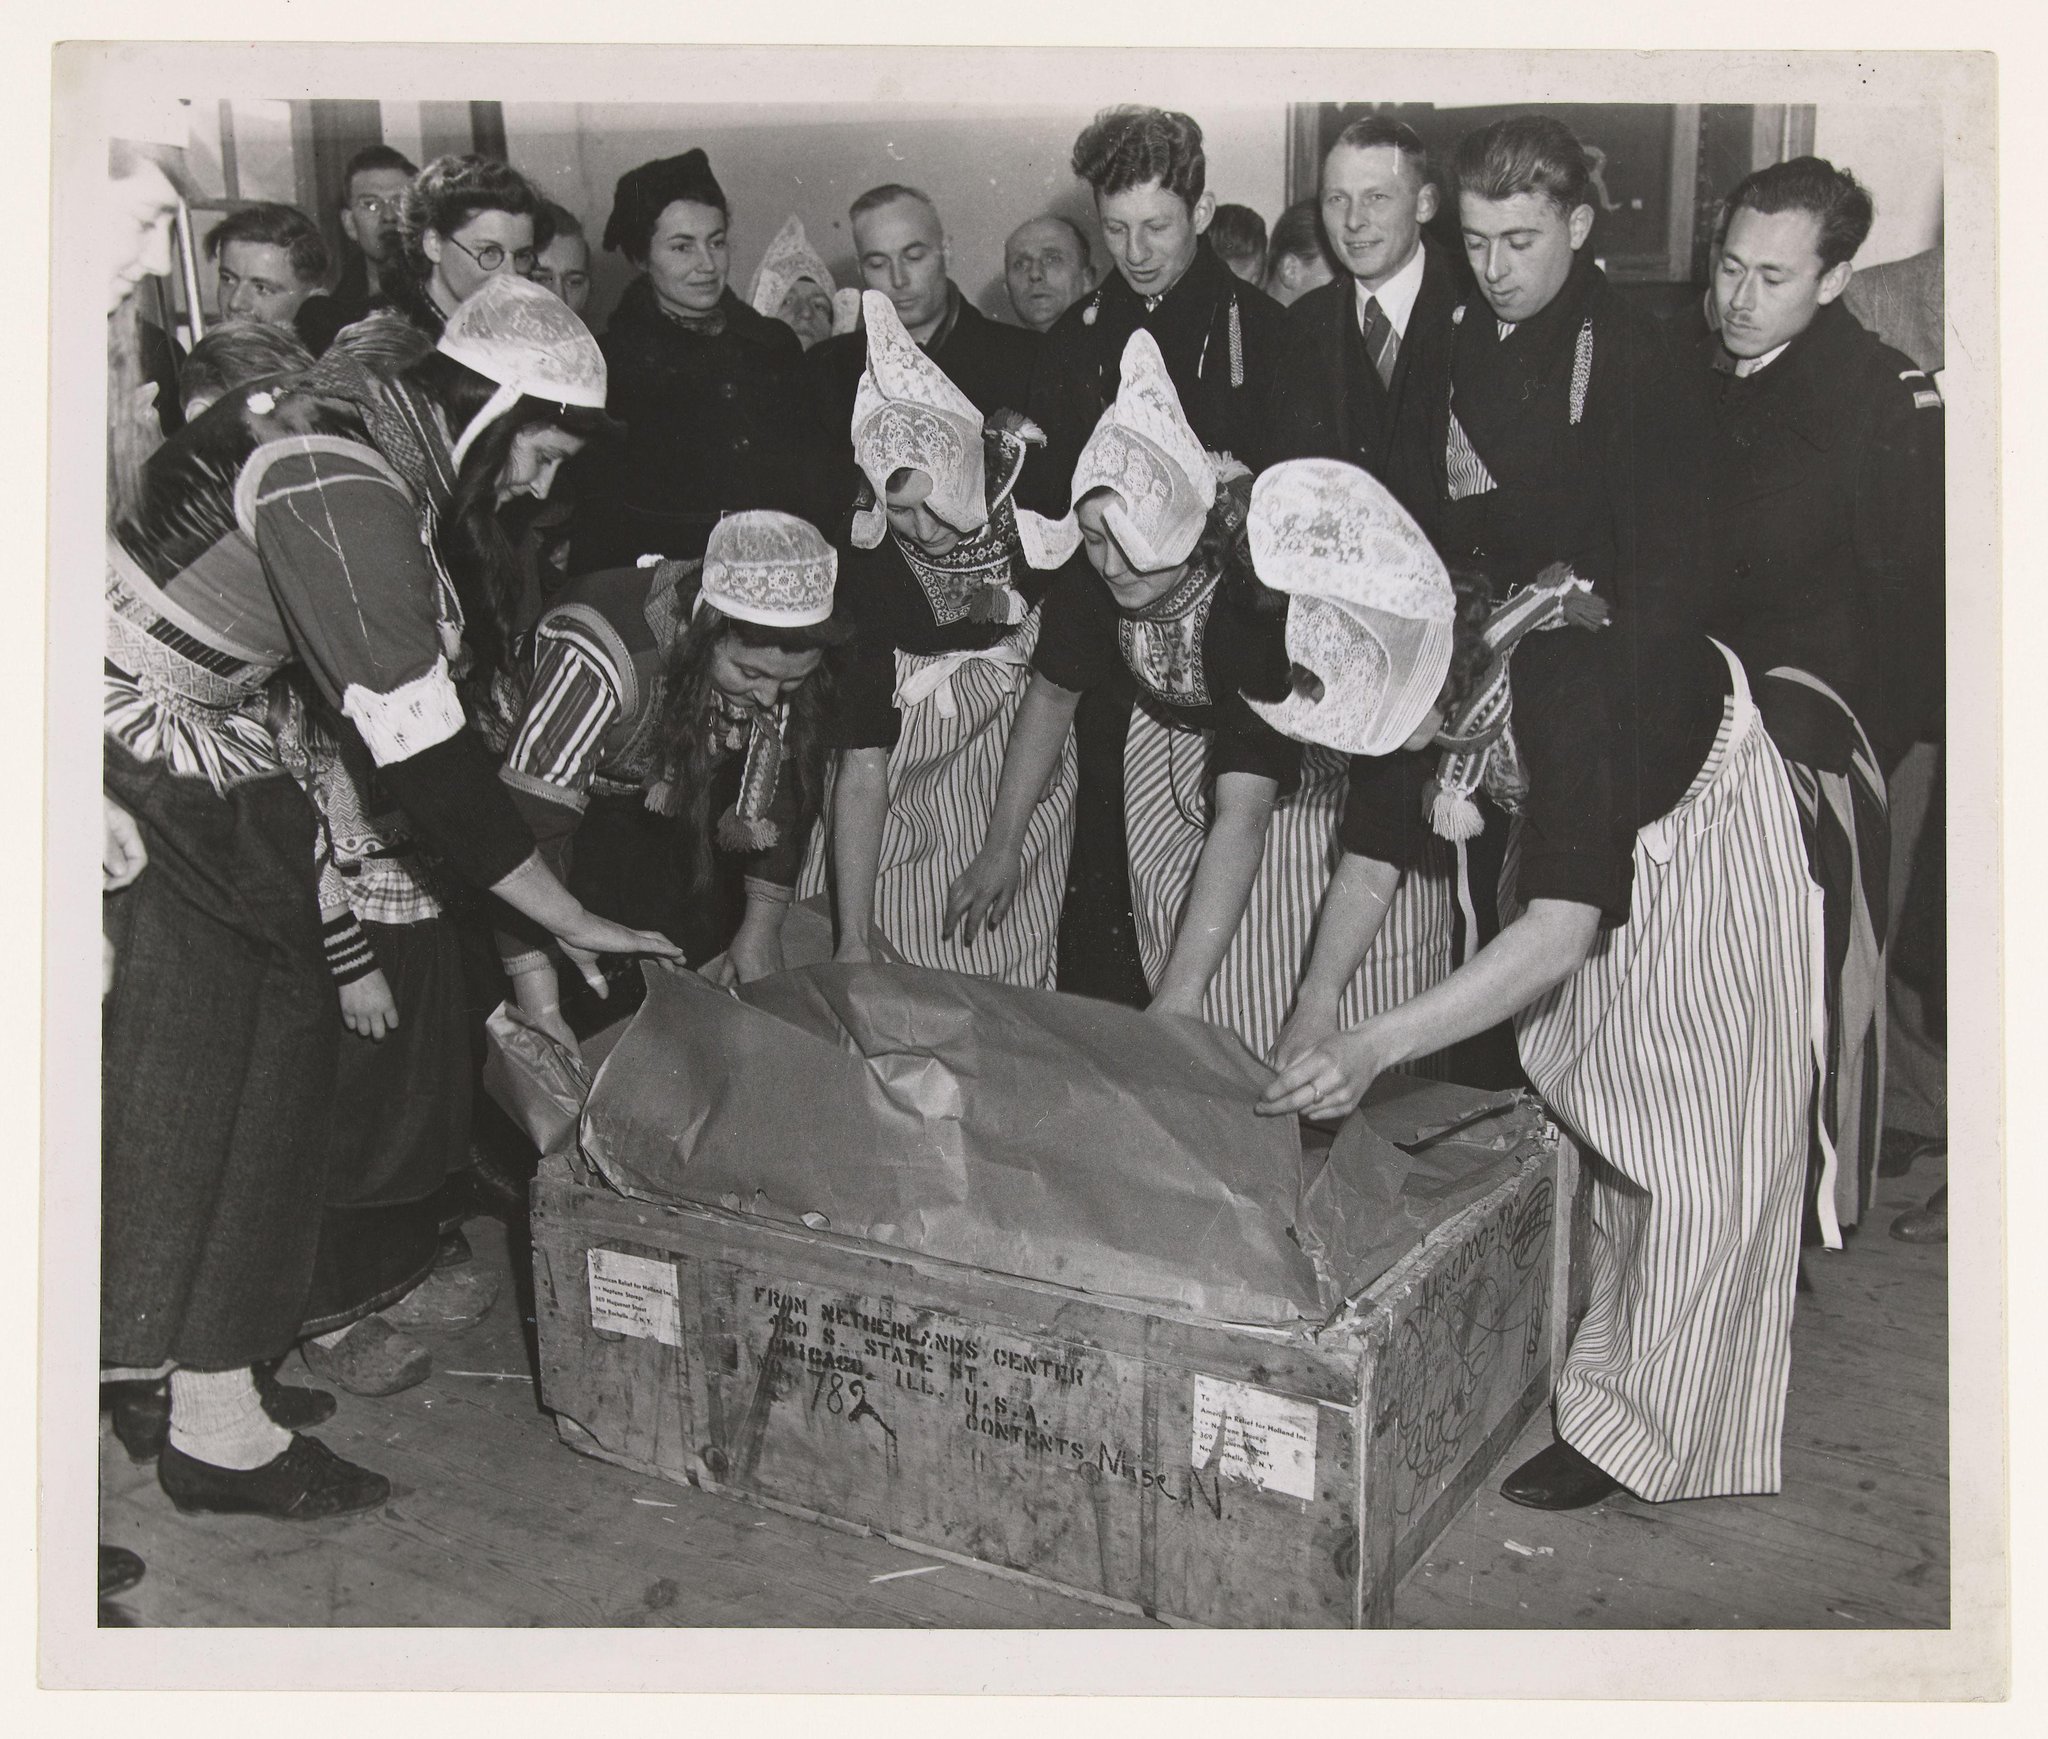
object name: documentary photograph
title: 1000e H.A.R.K. kist voor Volendam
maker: koos raucamp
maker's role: fotograaf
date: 1912-1945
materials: photographic support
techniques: photography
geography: volendam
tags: ons vrije nederland, volendam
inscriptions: number: ‘12806’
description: Vijf Volendamse meisjes in klederdracht pakken onder grote belangstelling een kist met levensmiddelen en kleding uit. Deze kist is door de American Relief for Holland Inc -afdeling Mid-West-, een organisatie van in Amerika wonende Hollanders, bijeengebracht. Deze kist bevatte voornamelijke textiel.